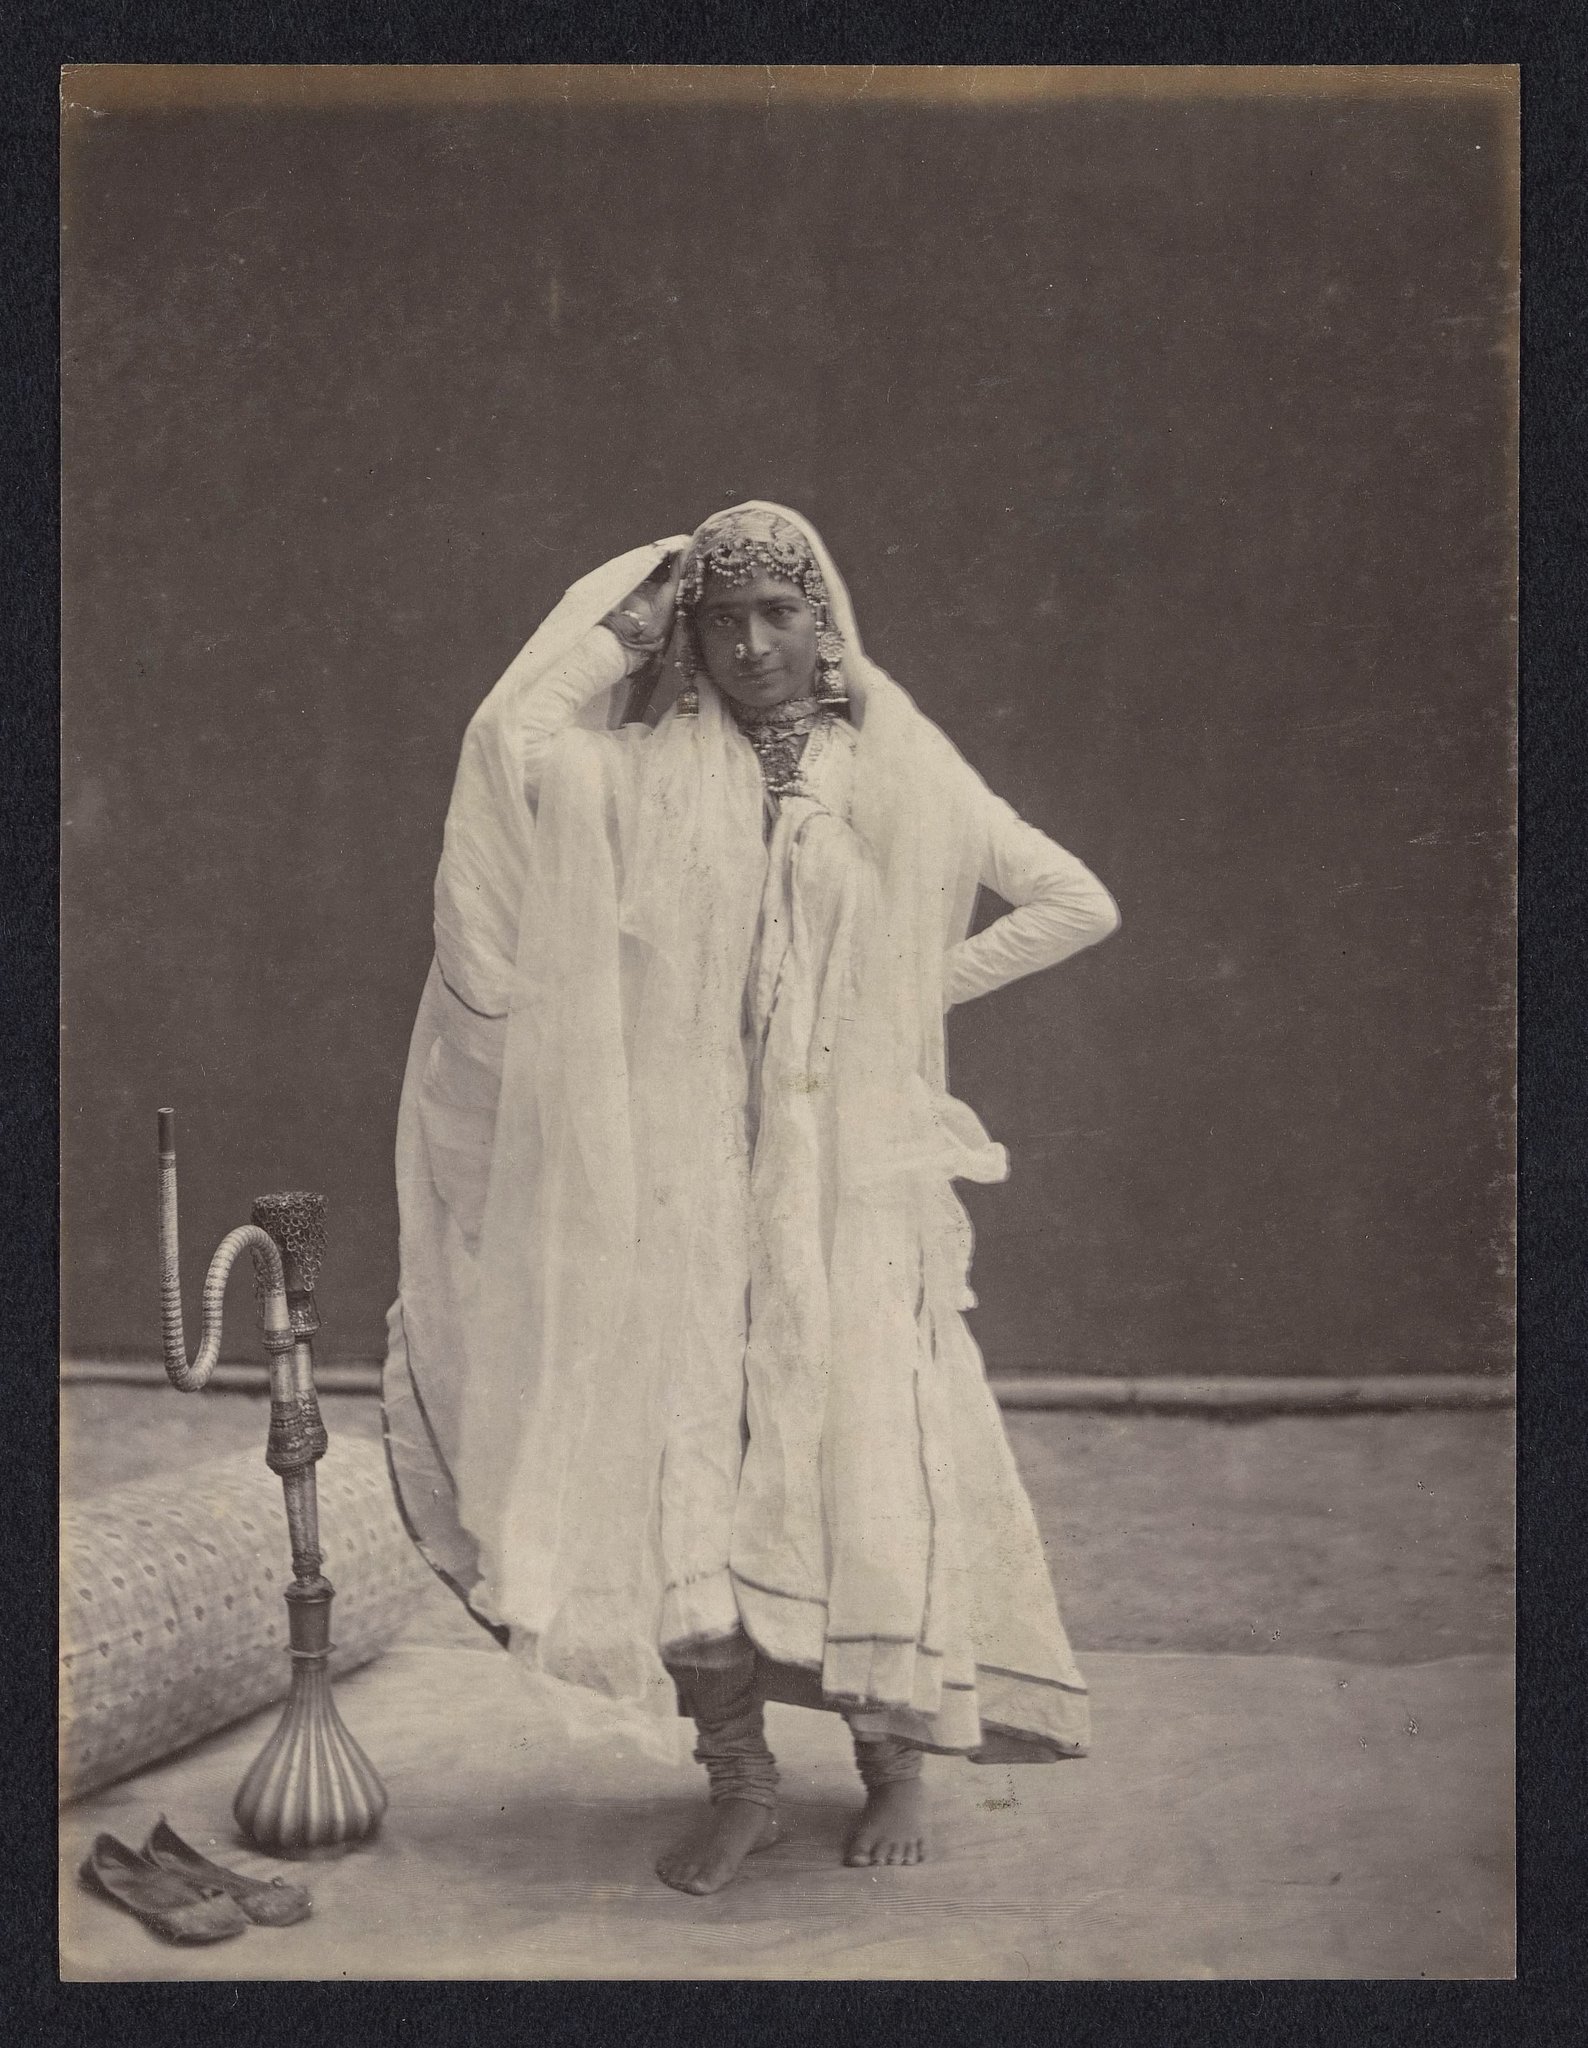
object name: photograph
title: Potrait of an unknown lady beside a sheesha, Jammu & Kashmir, India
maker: Anonymous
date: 1860-1870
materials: paper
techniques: albumen print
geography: jammu and kashmir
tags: water-pipe, hookah, narghile, adolescent, young woman, maiden, anonymous historical person portrayed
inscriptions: number: ‘3191’, title: ‘Cashmerian Nautch Girl/ Dancing Attitude’